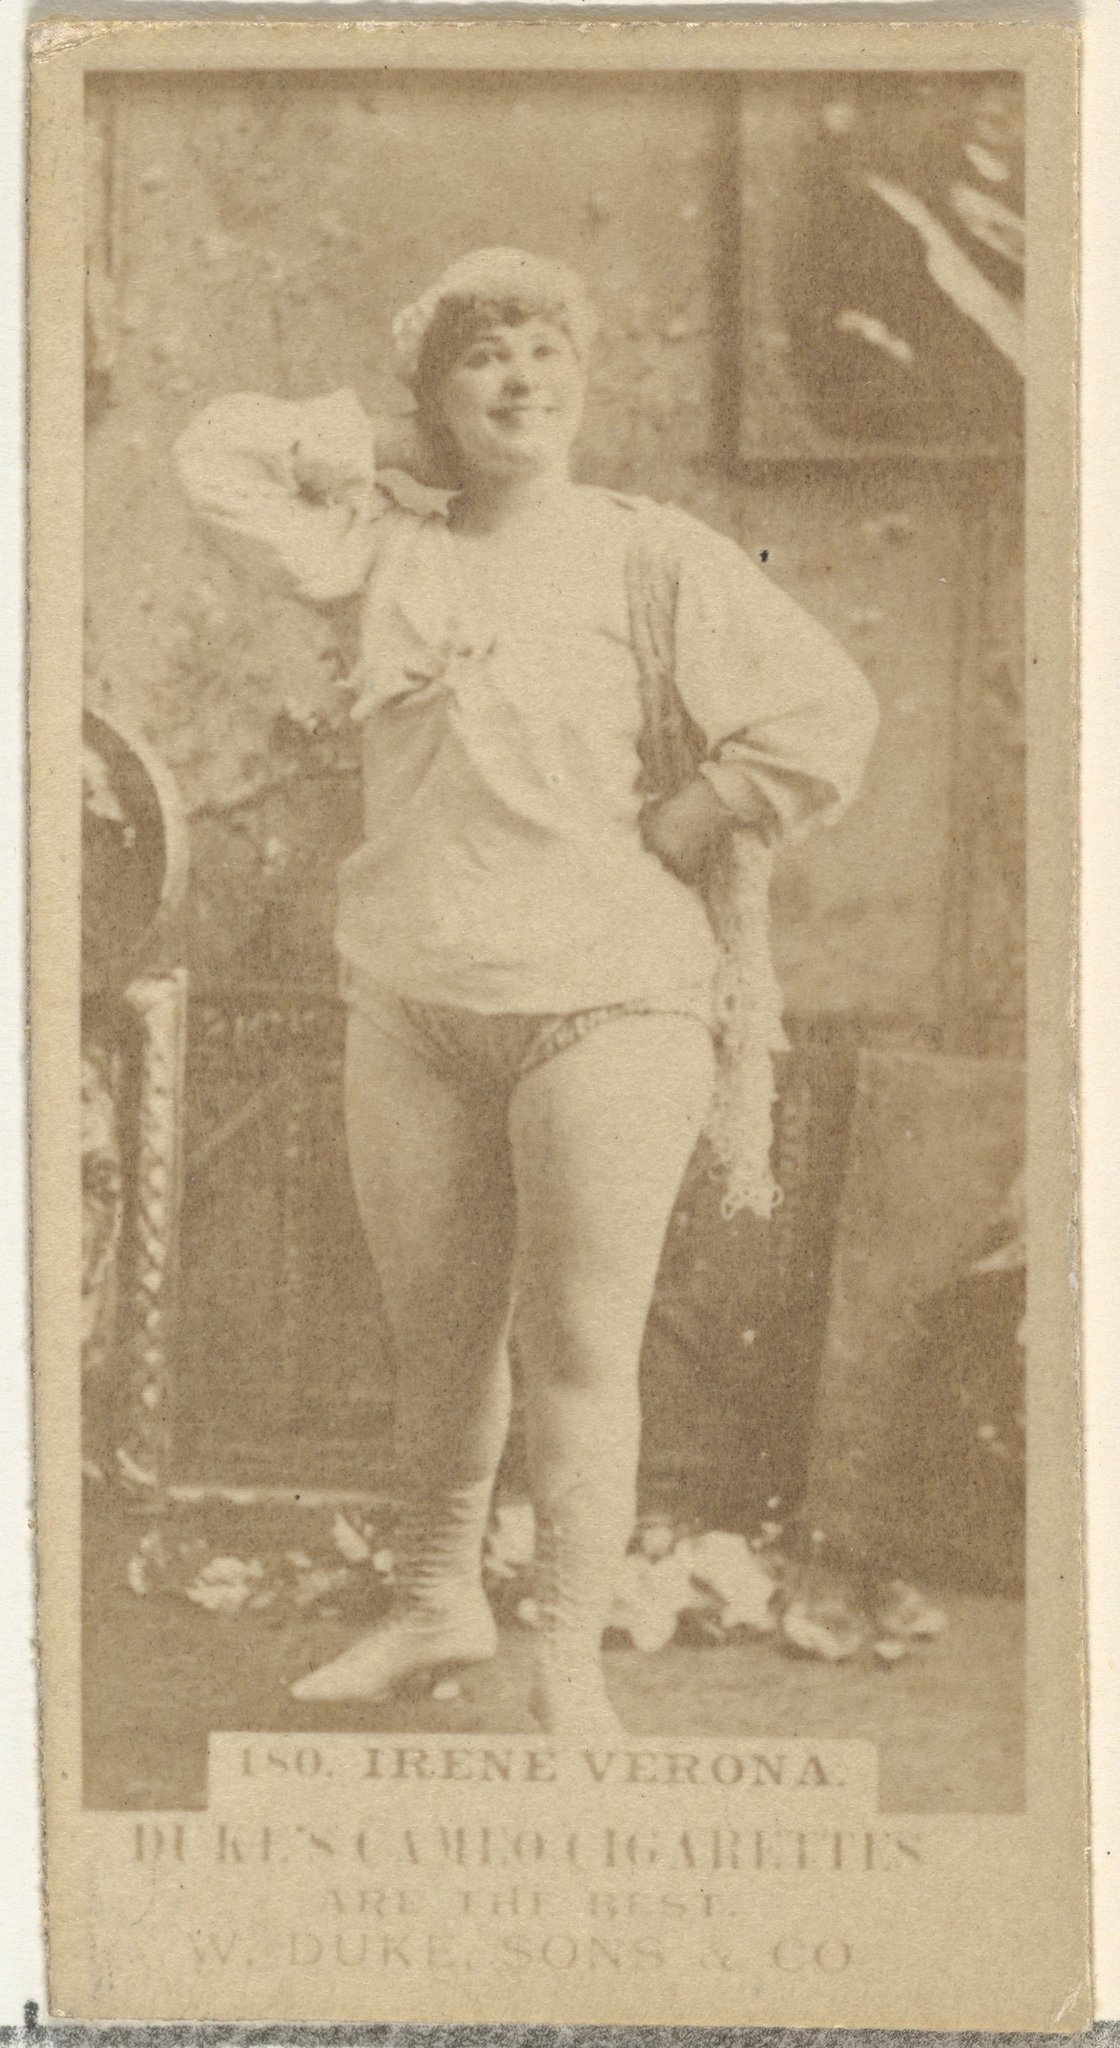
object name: photograph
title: Card Number 180, Irene Verona, from the Actors and Actresses series (N145-5) issued by Duke Sons & Co. to promote Cameo Cigarettes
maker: w. duke, sons & co.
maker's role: publisher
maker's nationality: american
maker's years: 1870-1920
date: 1880-1889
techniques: albumen silver print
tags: portraits,women,actresses